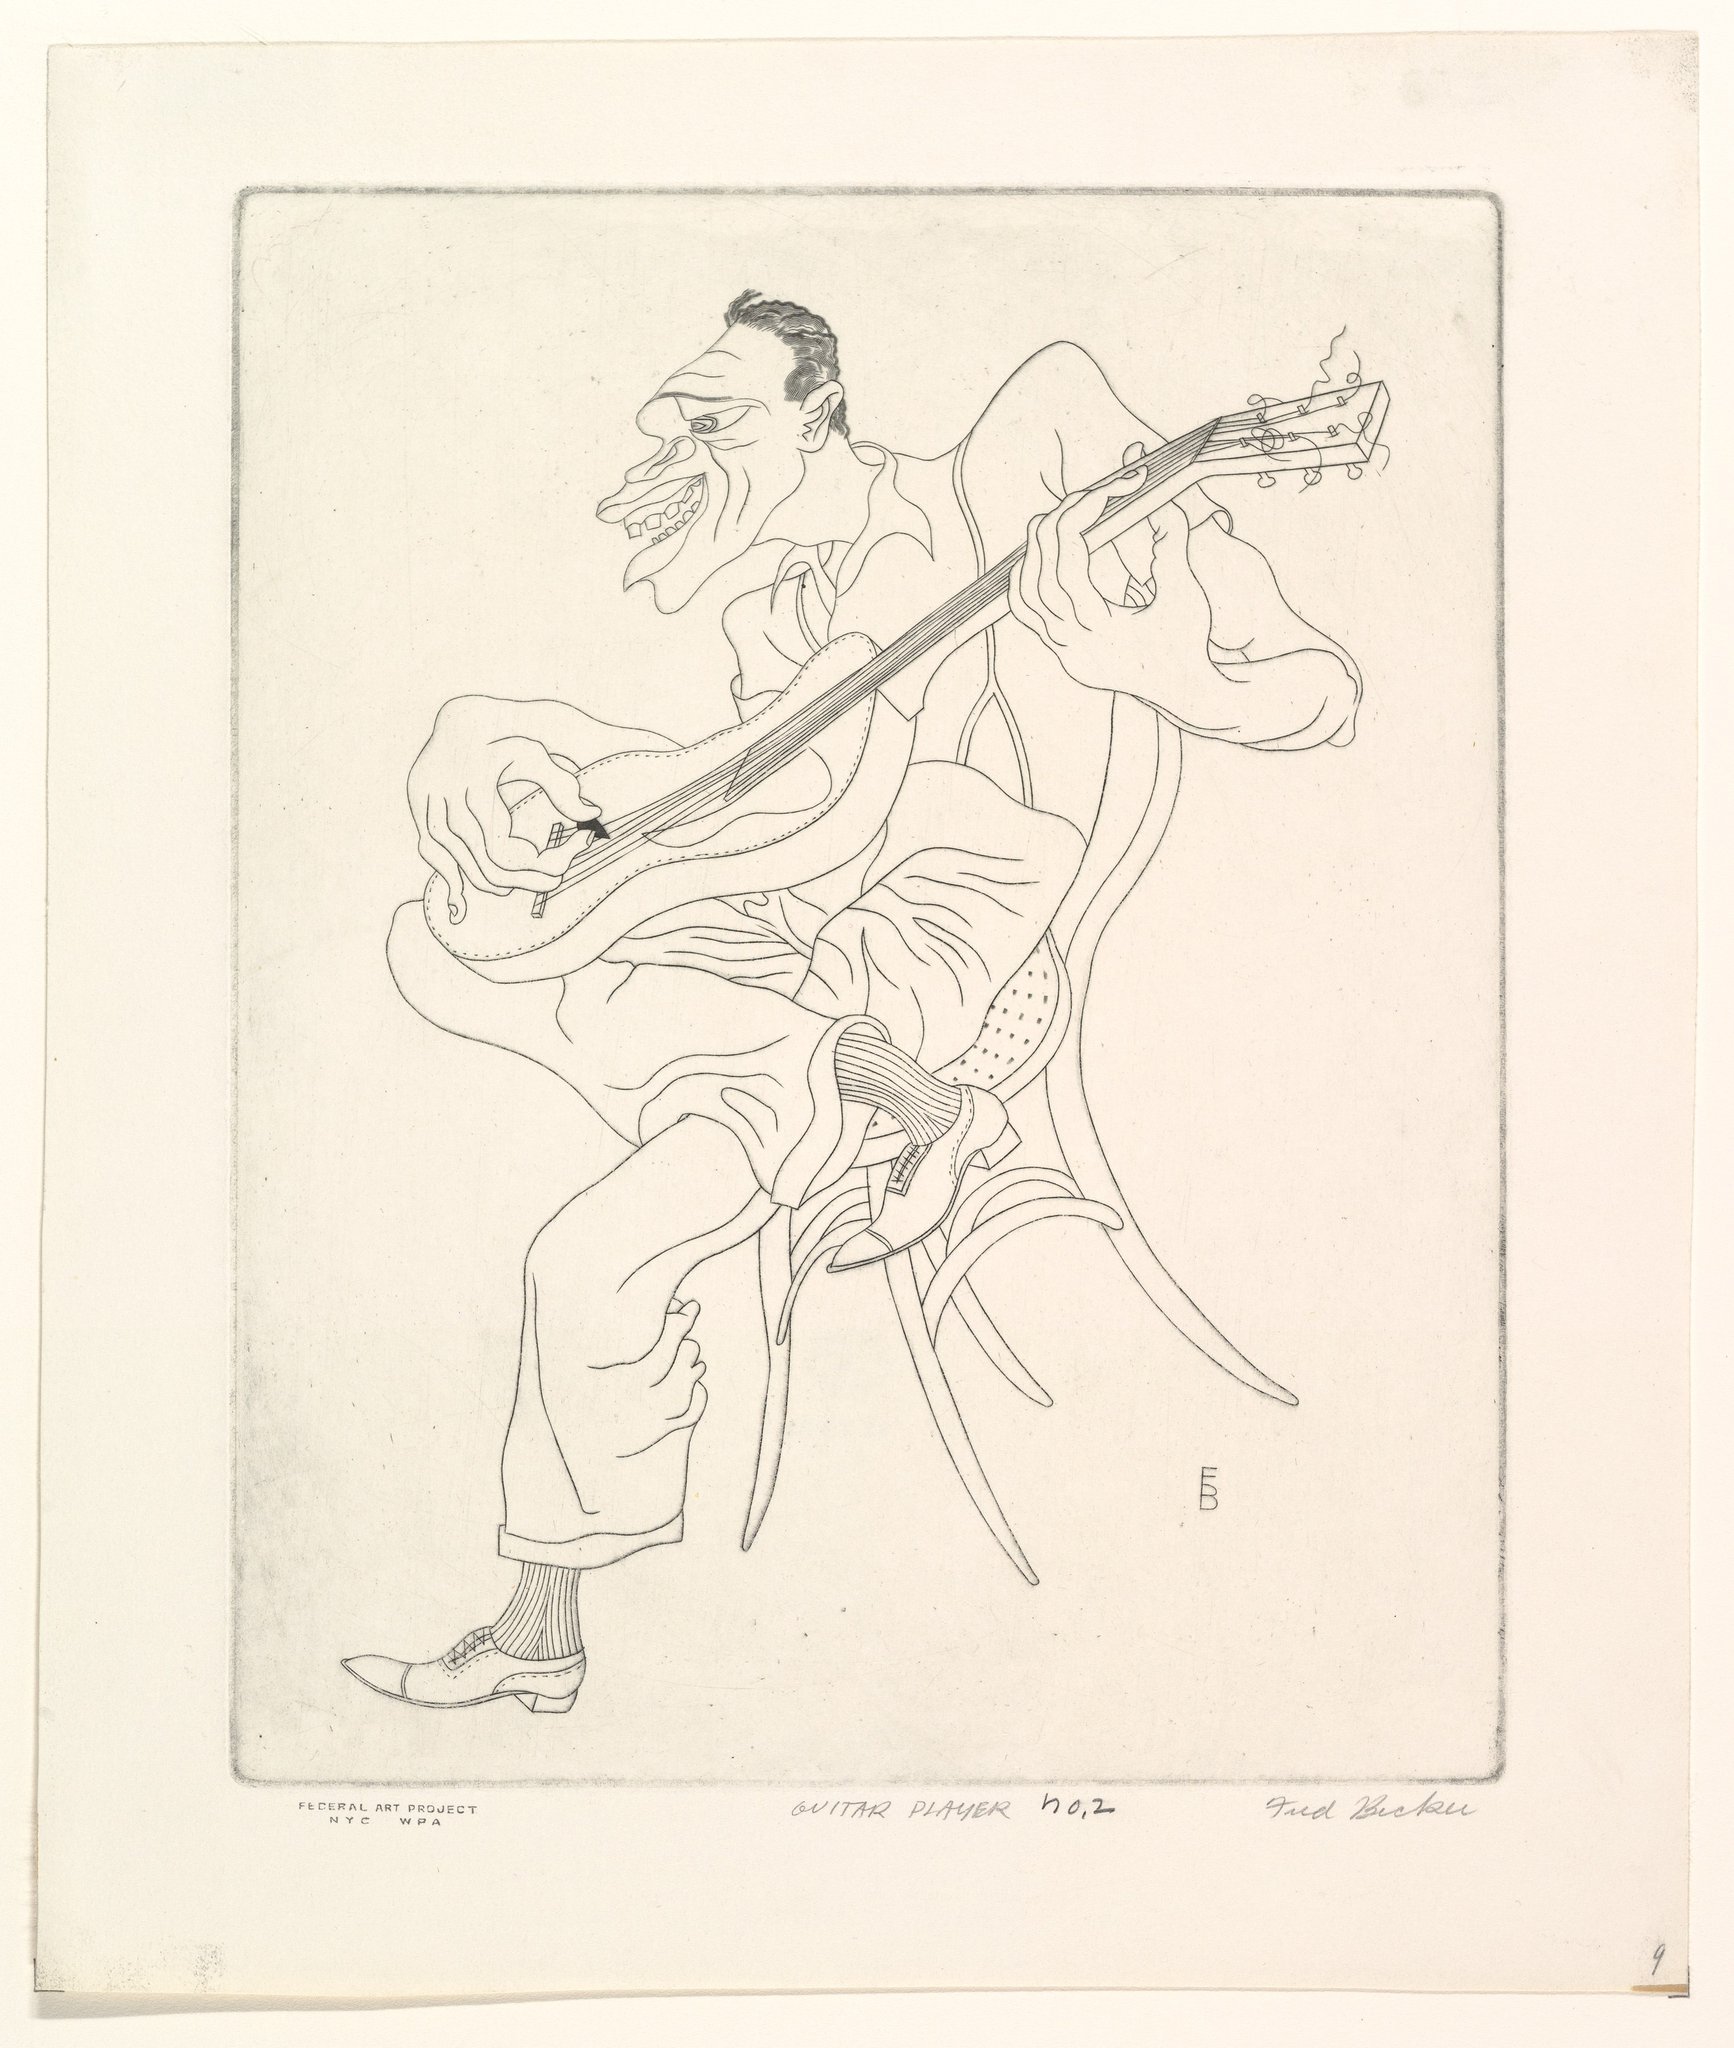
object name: print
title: Guitar Player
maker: fred becker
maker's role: artist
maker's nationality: american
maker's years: 1913-2004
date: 1935-1939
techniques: etching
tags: men,guitars,musicians